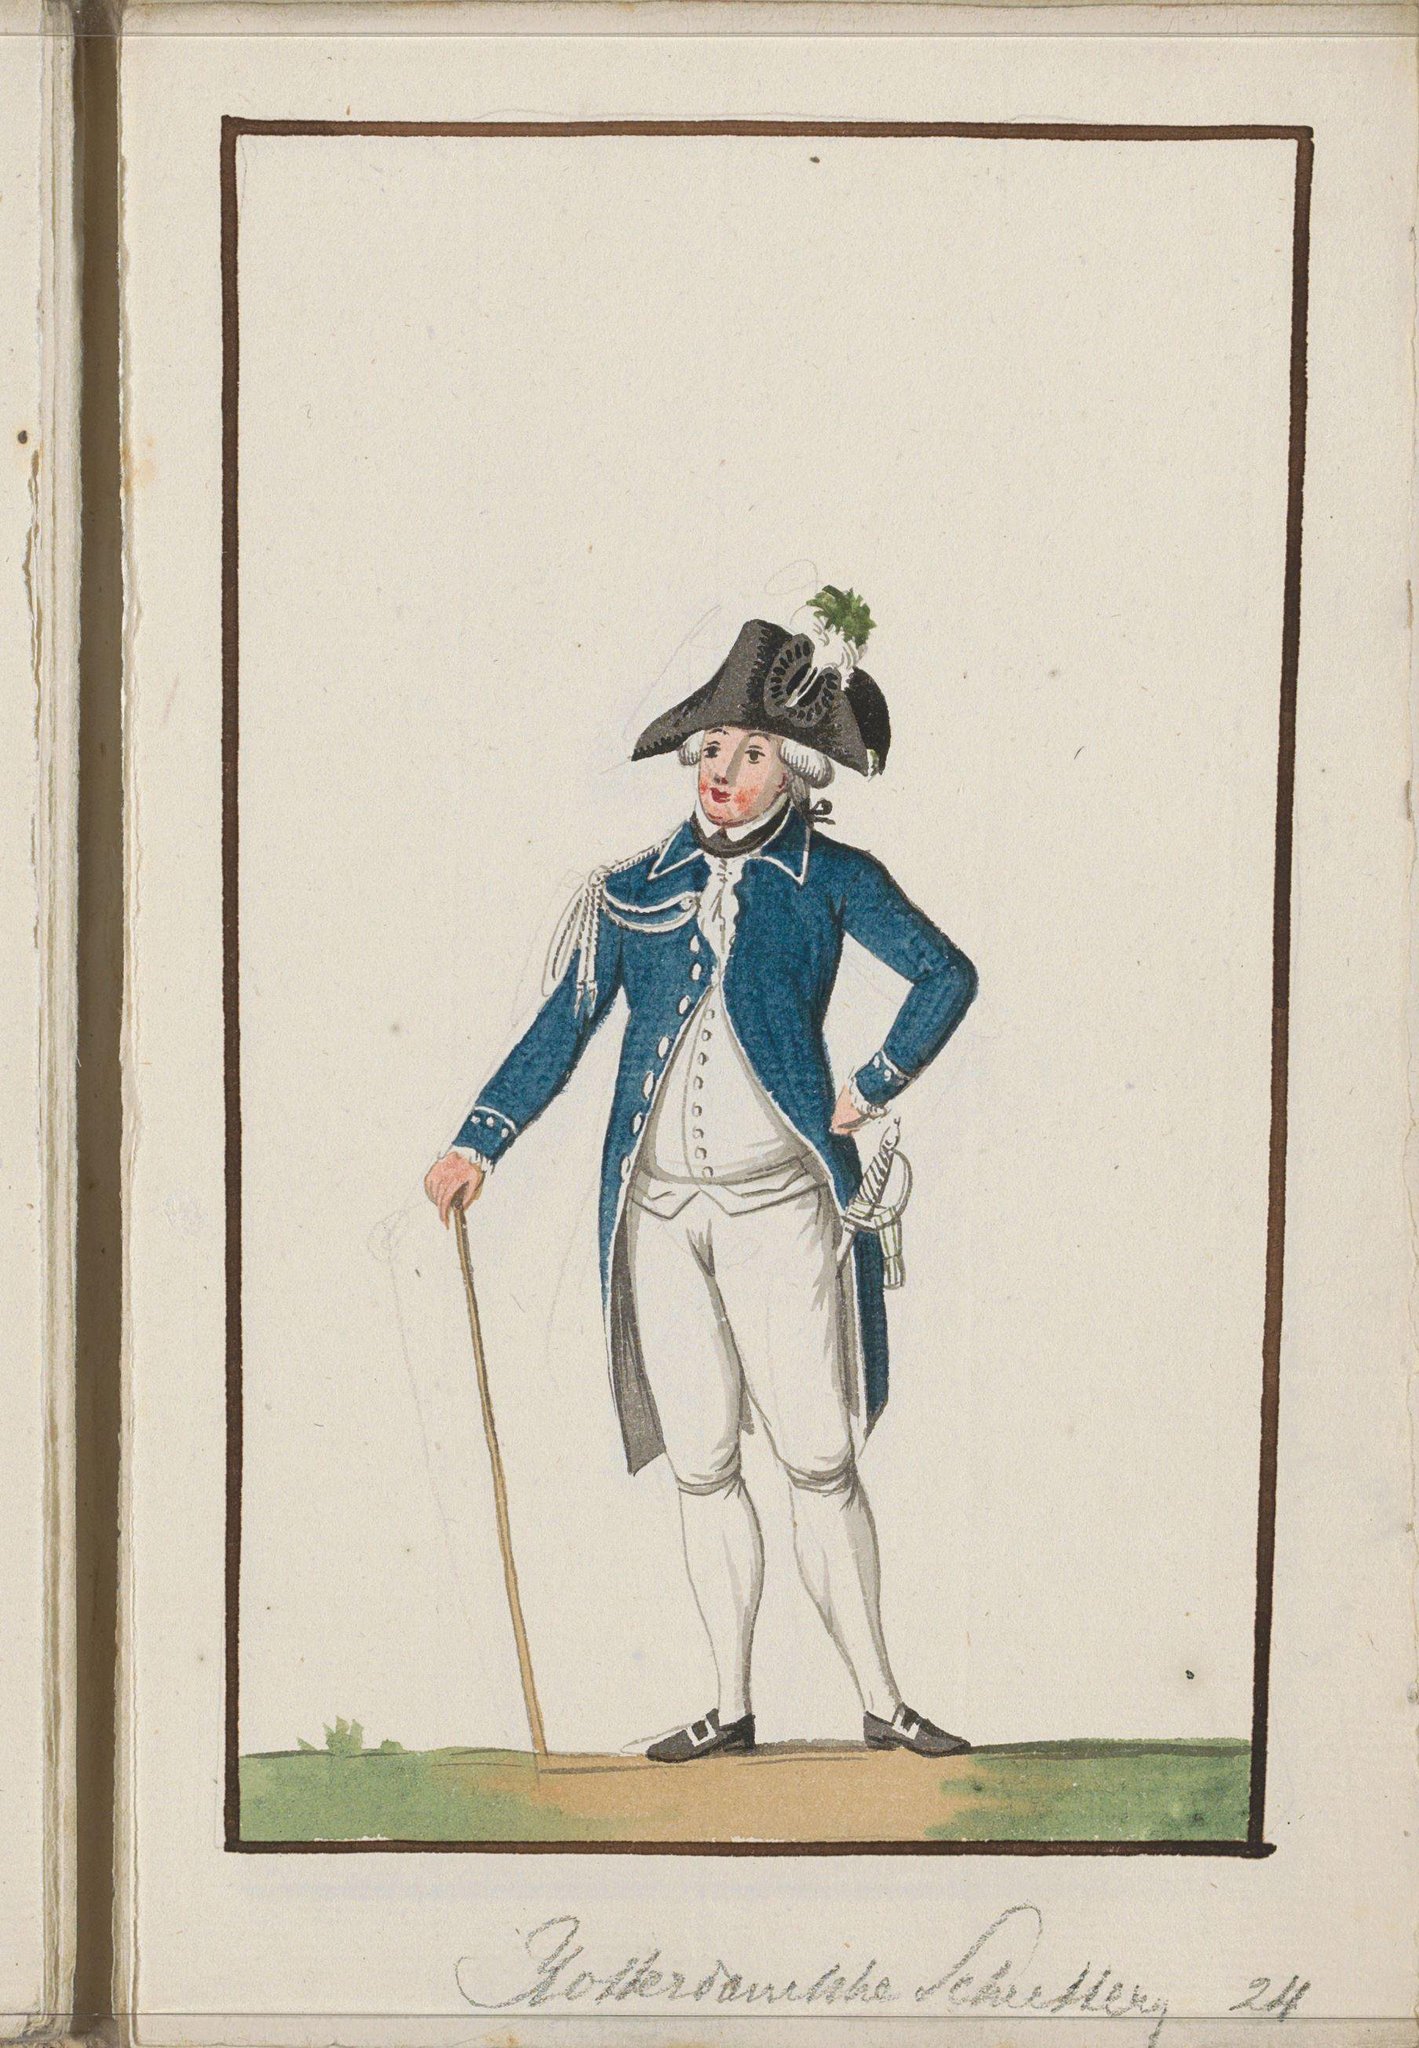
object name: drawing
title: Montering van schutterij van Rotterdam, ca. 1785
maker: Anonymous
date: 1789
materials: paper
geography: northern netherlands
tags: (military) uniforms (+ citizen soldiery, civil guard, citizen militia), rotterdam, patriots (1780-1795)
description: Montering of uniform van de schutterij van Rotterdam, ca. 1785. Onderdeel van een schetsboek met 41 gekleurde tekeningen van de monteringen van de gewapende schutterijen en burgercorpsen in Nederland in de periode ca. 1783-1789.